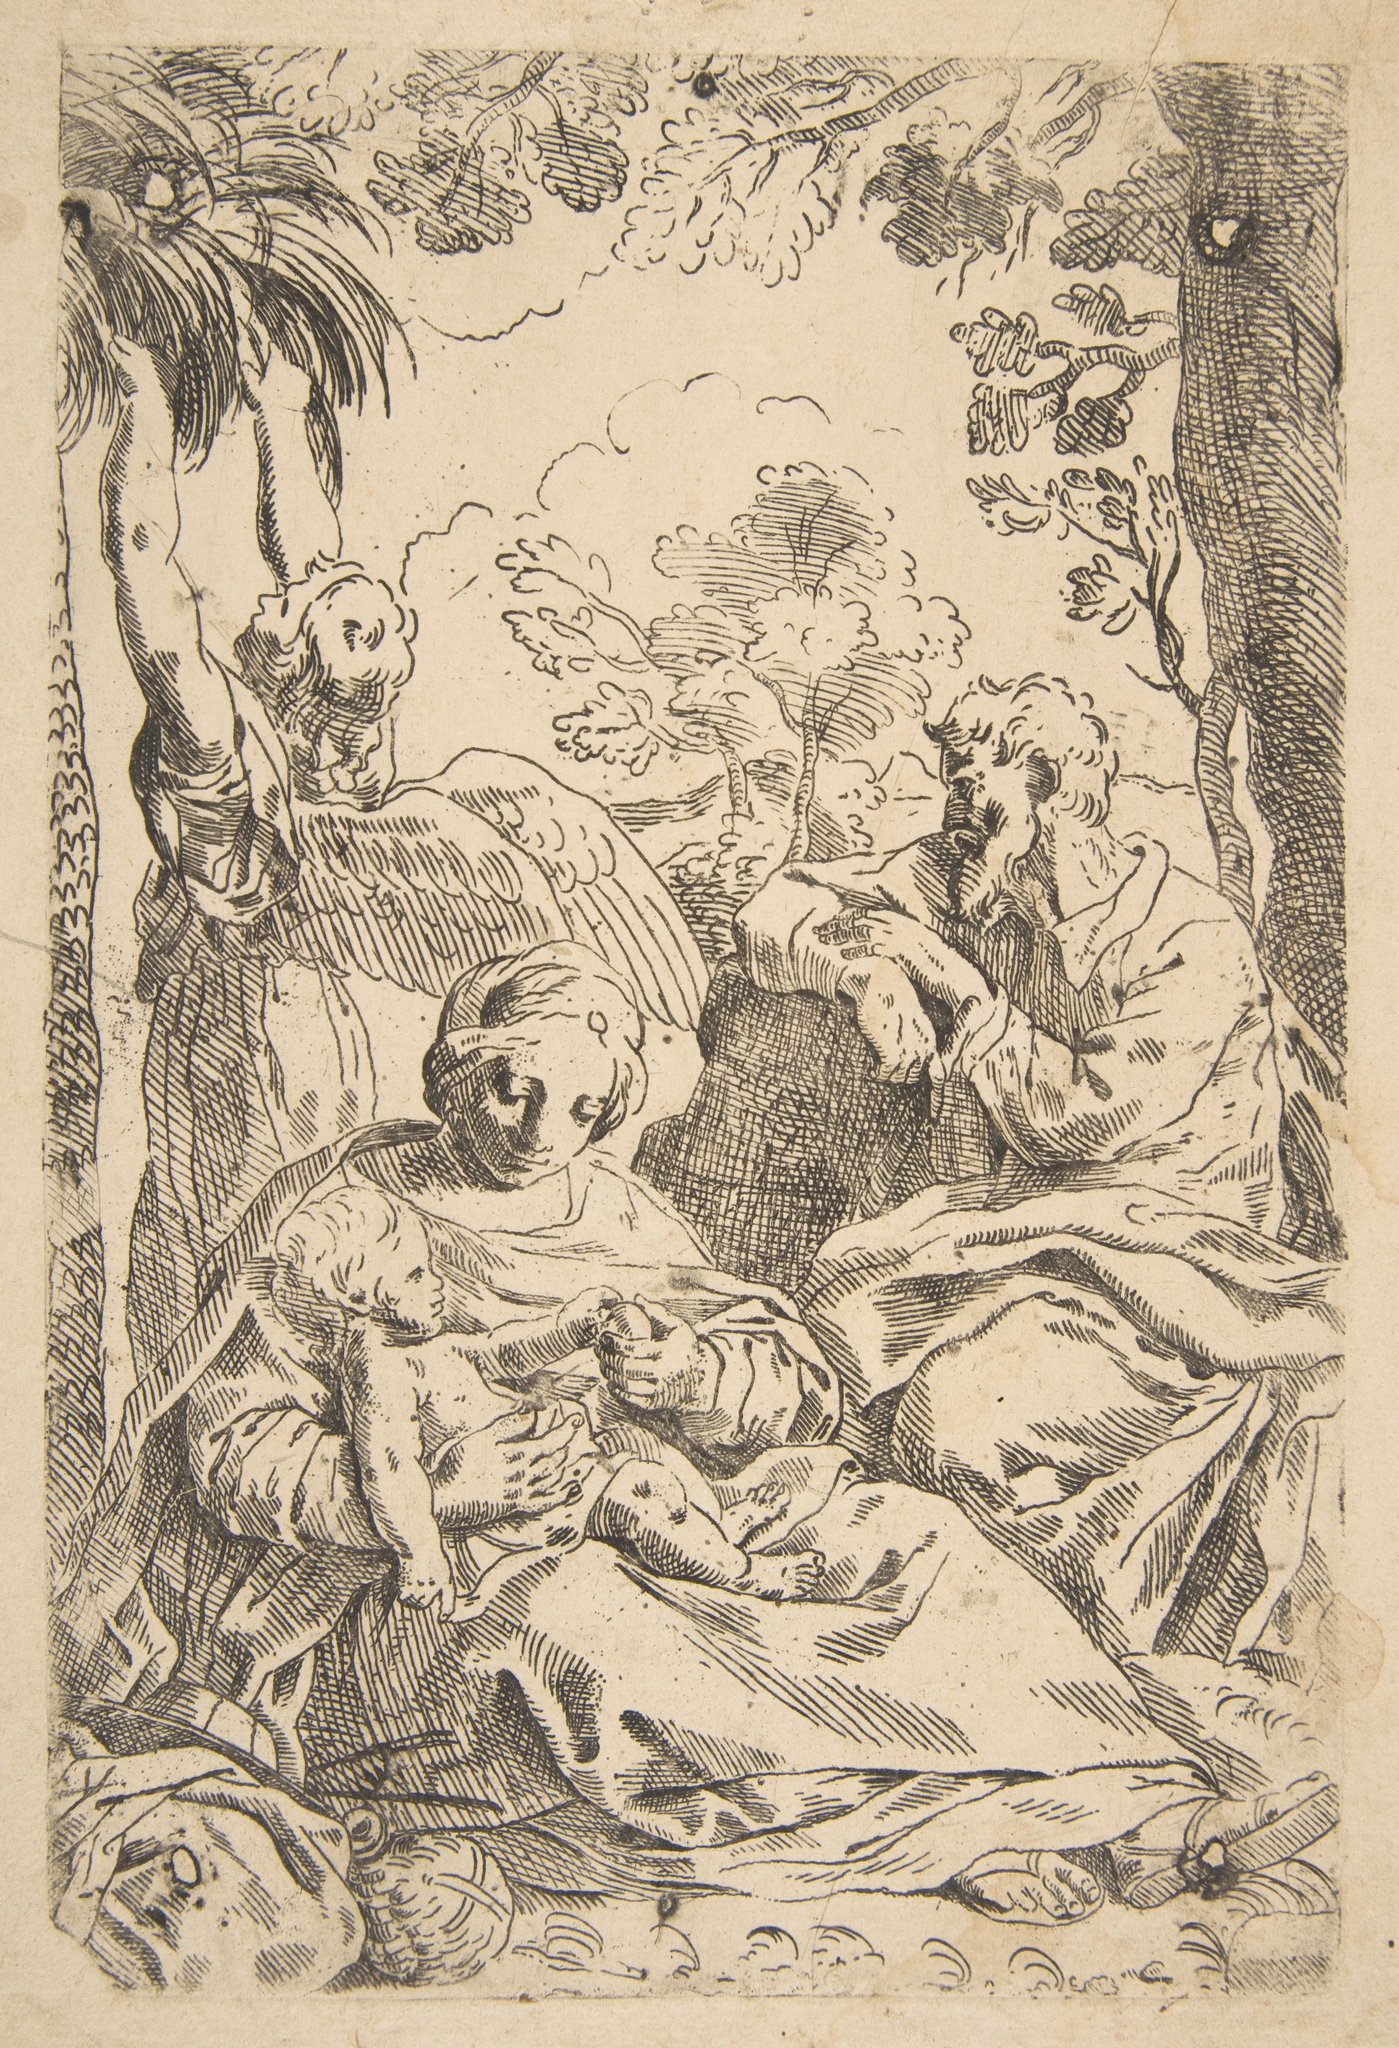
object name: print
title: Repose in Egypt, Holy Family seated while an angel pulls at tree branches, copy after Cantarini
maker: simone cantarini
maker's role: artist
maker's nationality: italian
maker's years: 1612-1648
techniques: etching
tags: trees,angels,holy family